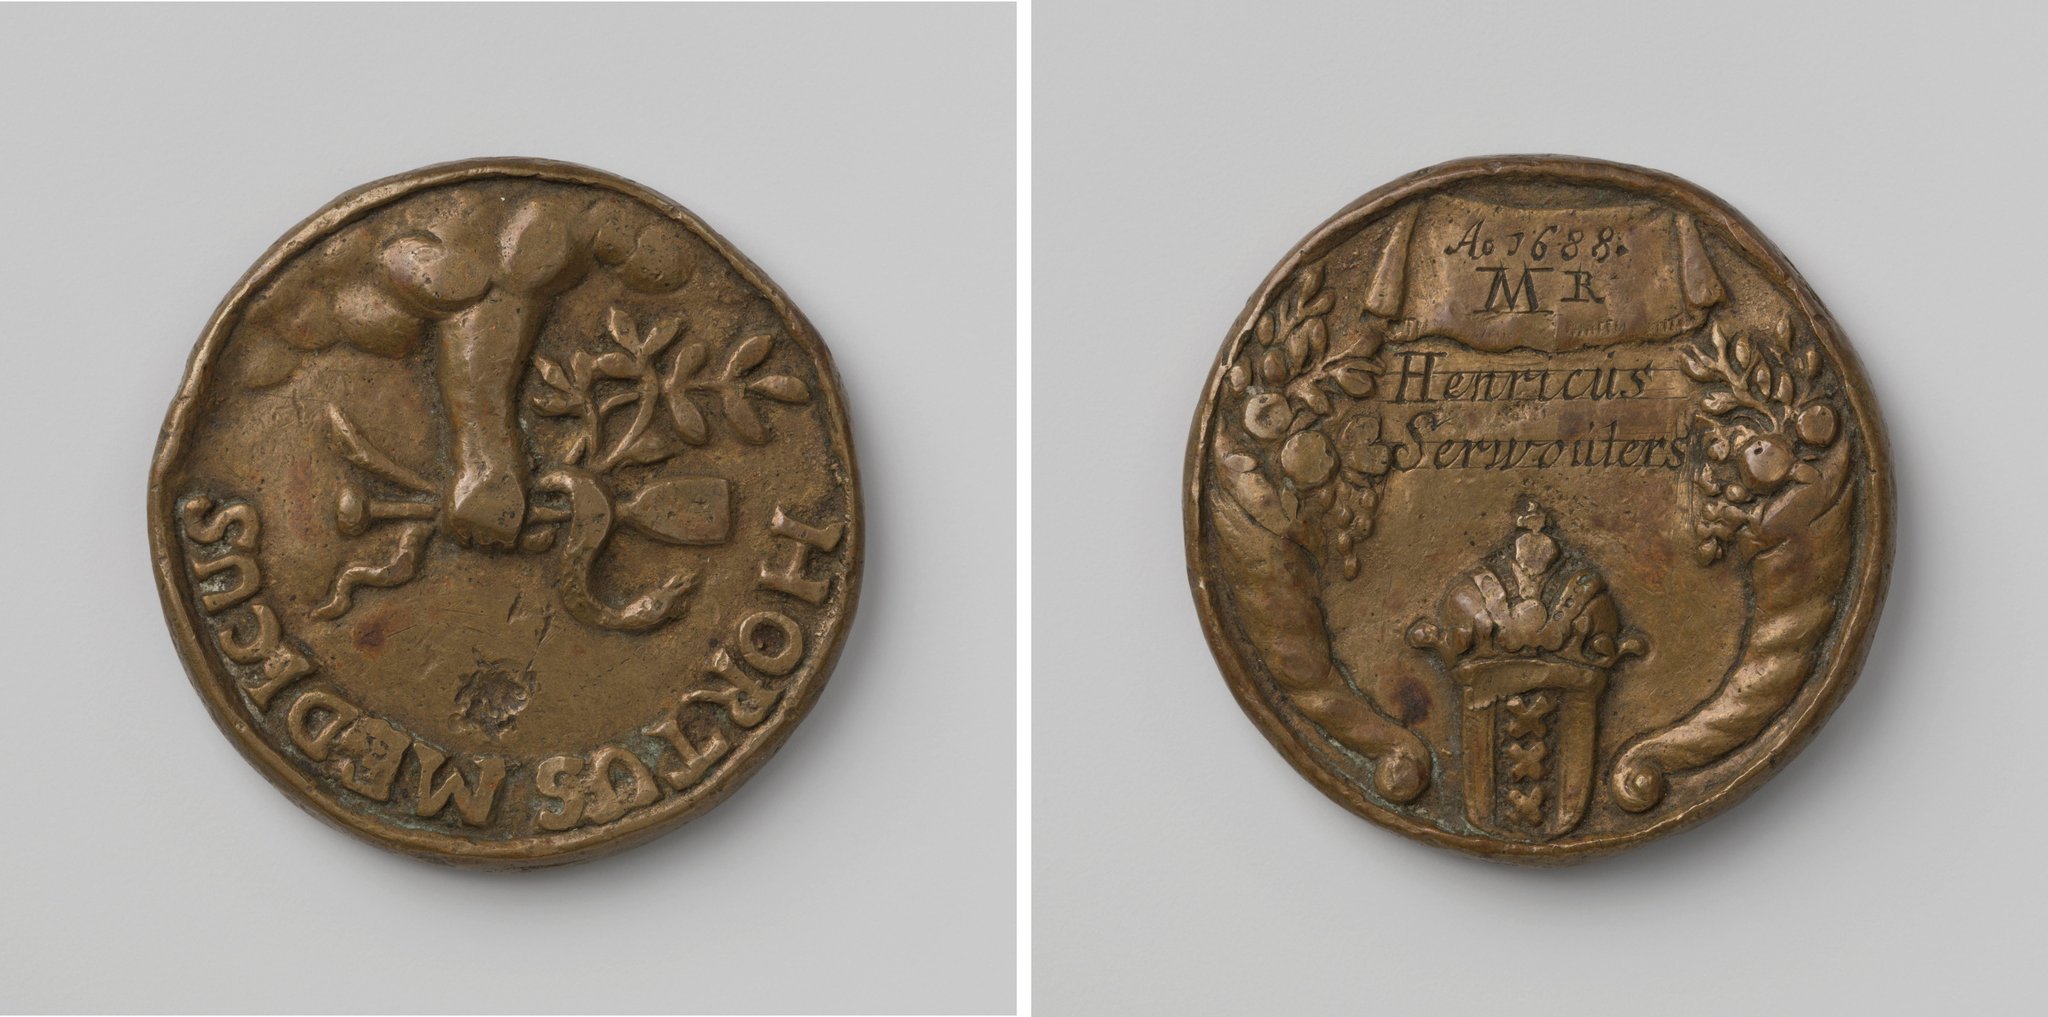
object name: toegangspenning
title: Collegium Medicum te Amsterdam, toegangspenning voor de hortus medicus voor Henricus Serwouters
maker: aernout naghtegael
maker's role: print maker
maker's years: 1658-1745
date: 1684-1688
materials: brass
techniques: casting, engraving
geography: amsterdam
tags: amsterdam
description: Messing penning. Voorzijde: hand uit wolken houdt tak en zalfspatel vast, waarom slang zich kronkelt binnen omschrift. Keerzijde: gekroond wapenschild tussen twee gevulde hoorns van overvloed; daartussen: opschrift onder doek met opschrift